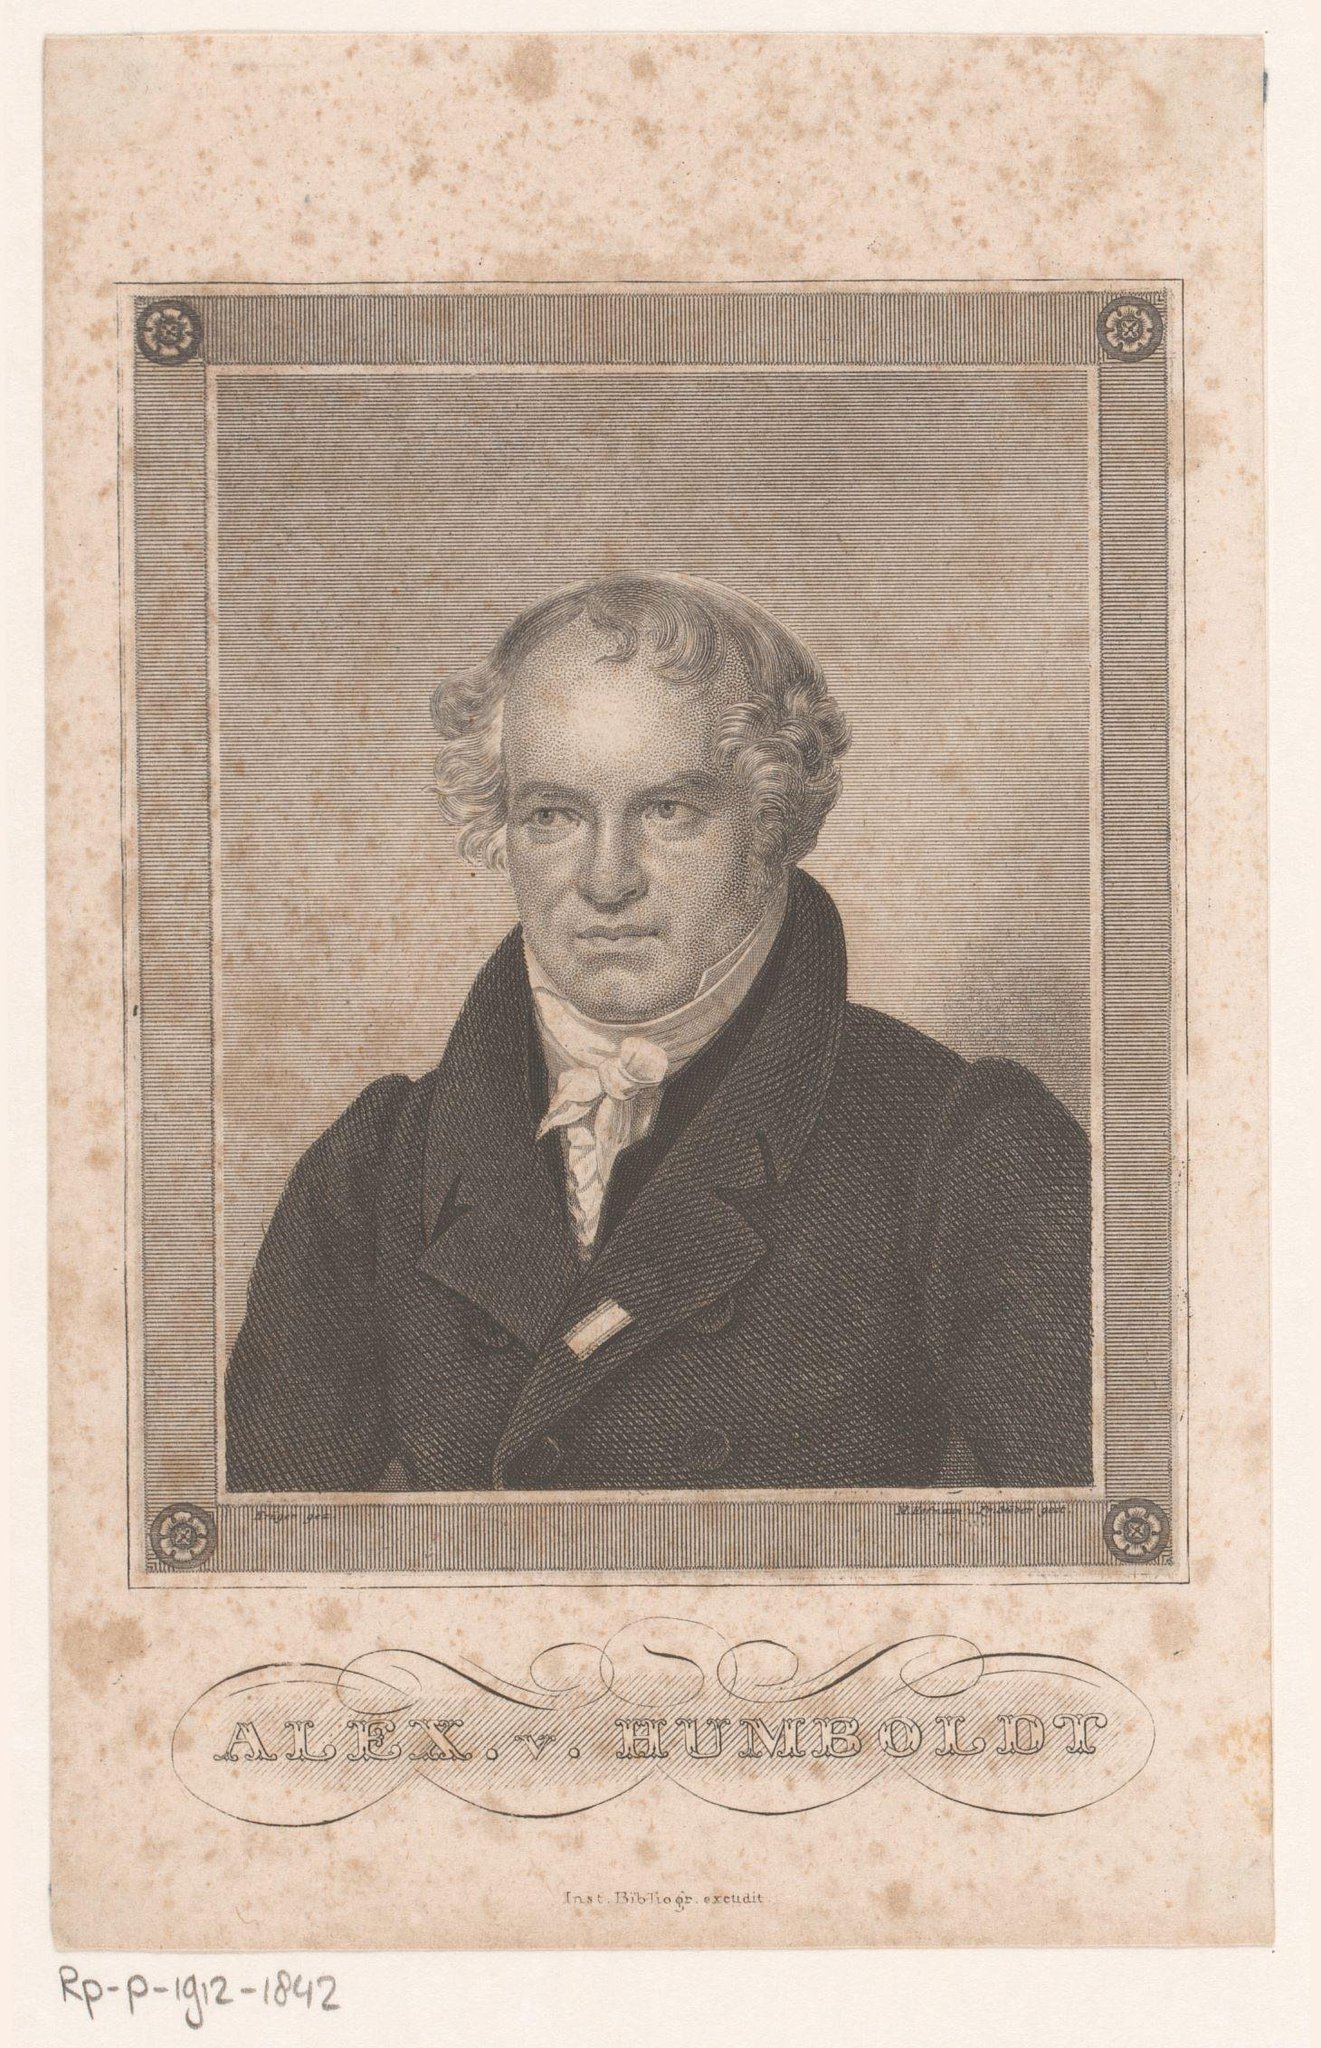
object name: print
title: Portret van Alexander von Humboldt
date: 1840-1855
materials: paper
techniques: engraving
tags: berlin, traveler, physics, historical persons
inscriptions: collector's mark: Lugt 2228